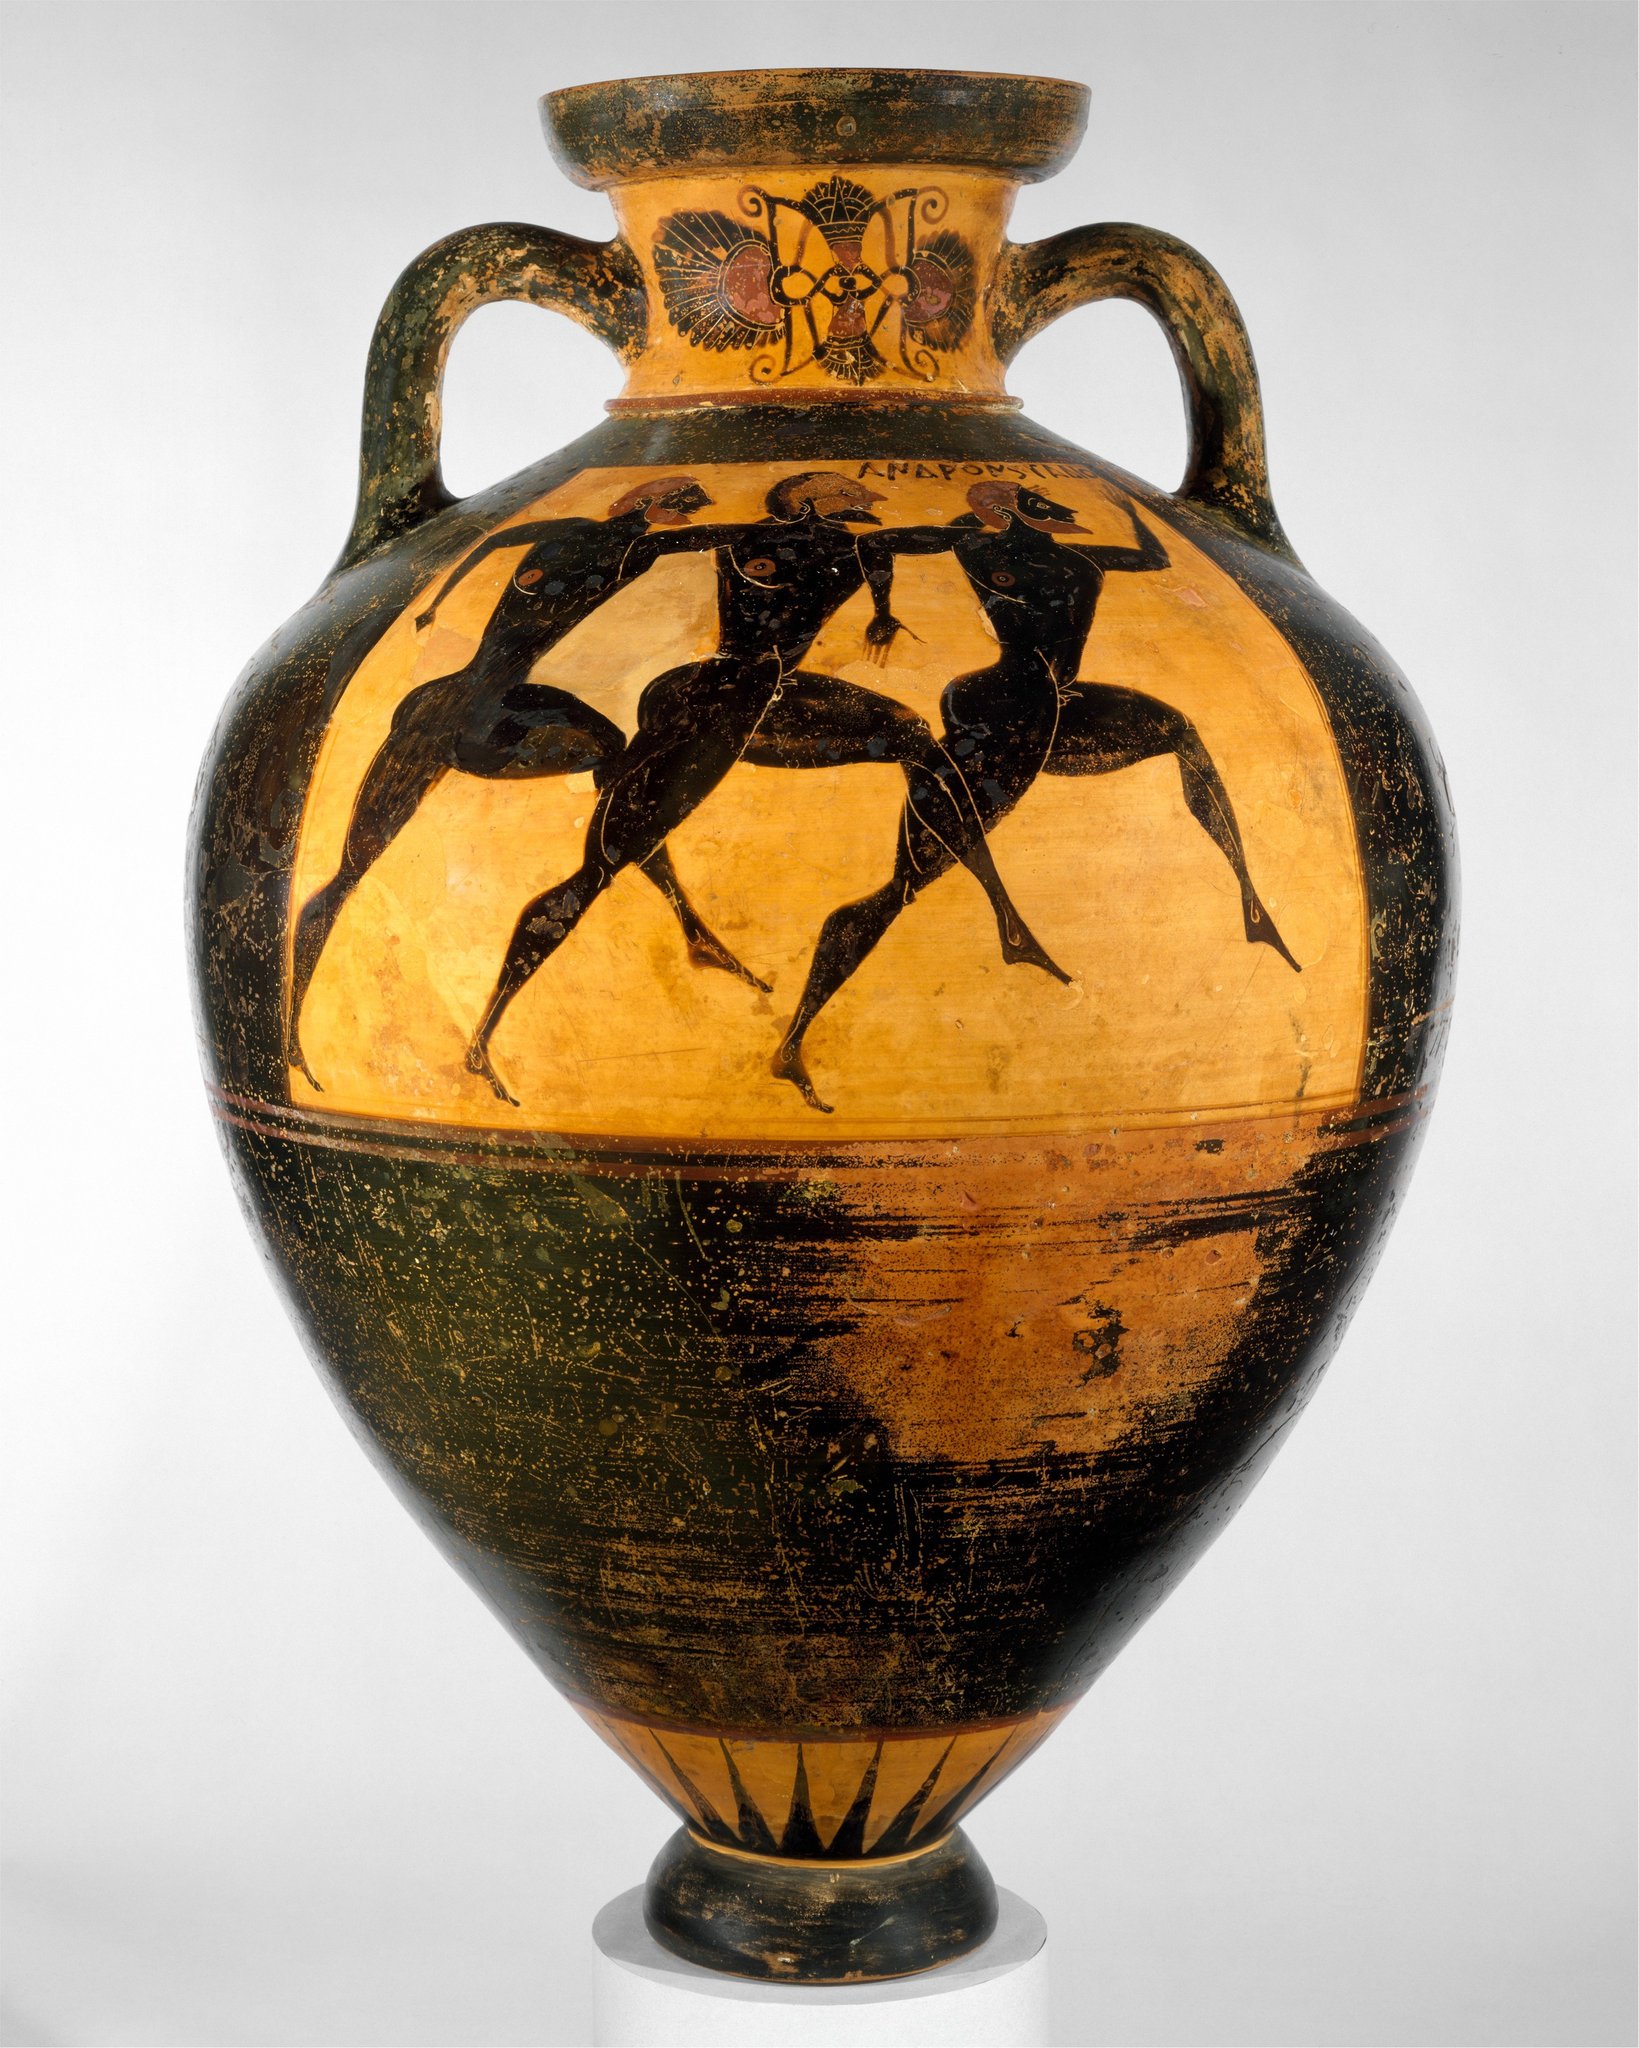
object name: panathenaic prize amphora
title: Terracotta Panathenaic prize amphora (jar)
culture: greek, attic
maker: nikias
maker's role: artist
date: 560-550 BCE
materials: terracotta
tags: shields,men,running,athena,athletes